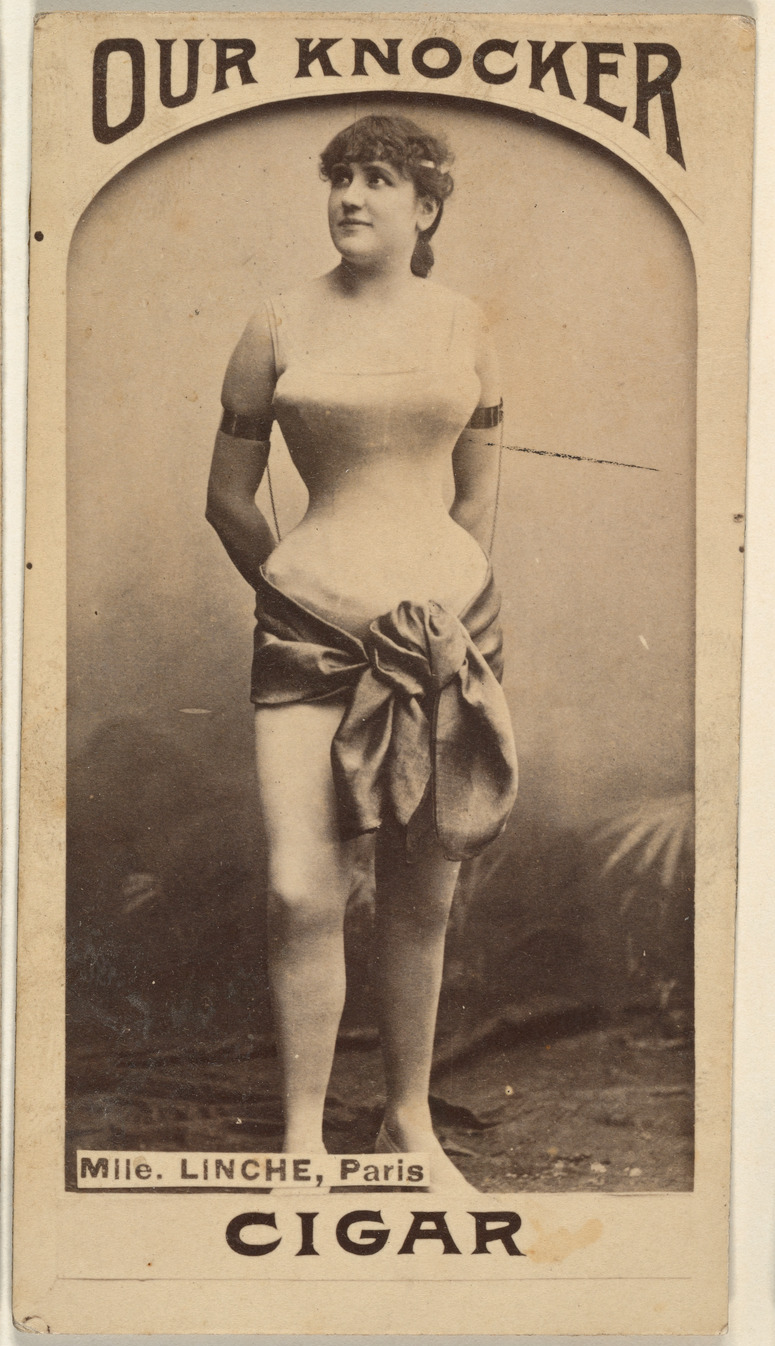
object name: photograph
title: Mlle. Linche, Paris, from the Actresses series (N665) promoting Our Knocker Cigars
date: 1888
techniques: albumen silver print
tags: portraits,women,actresses